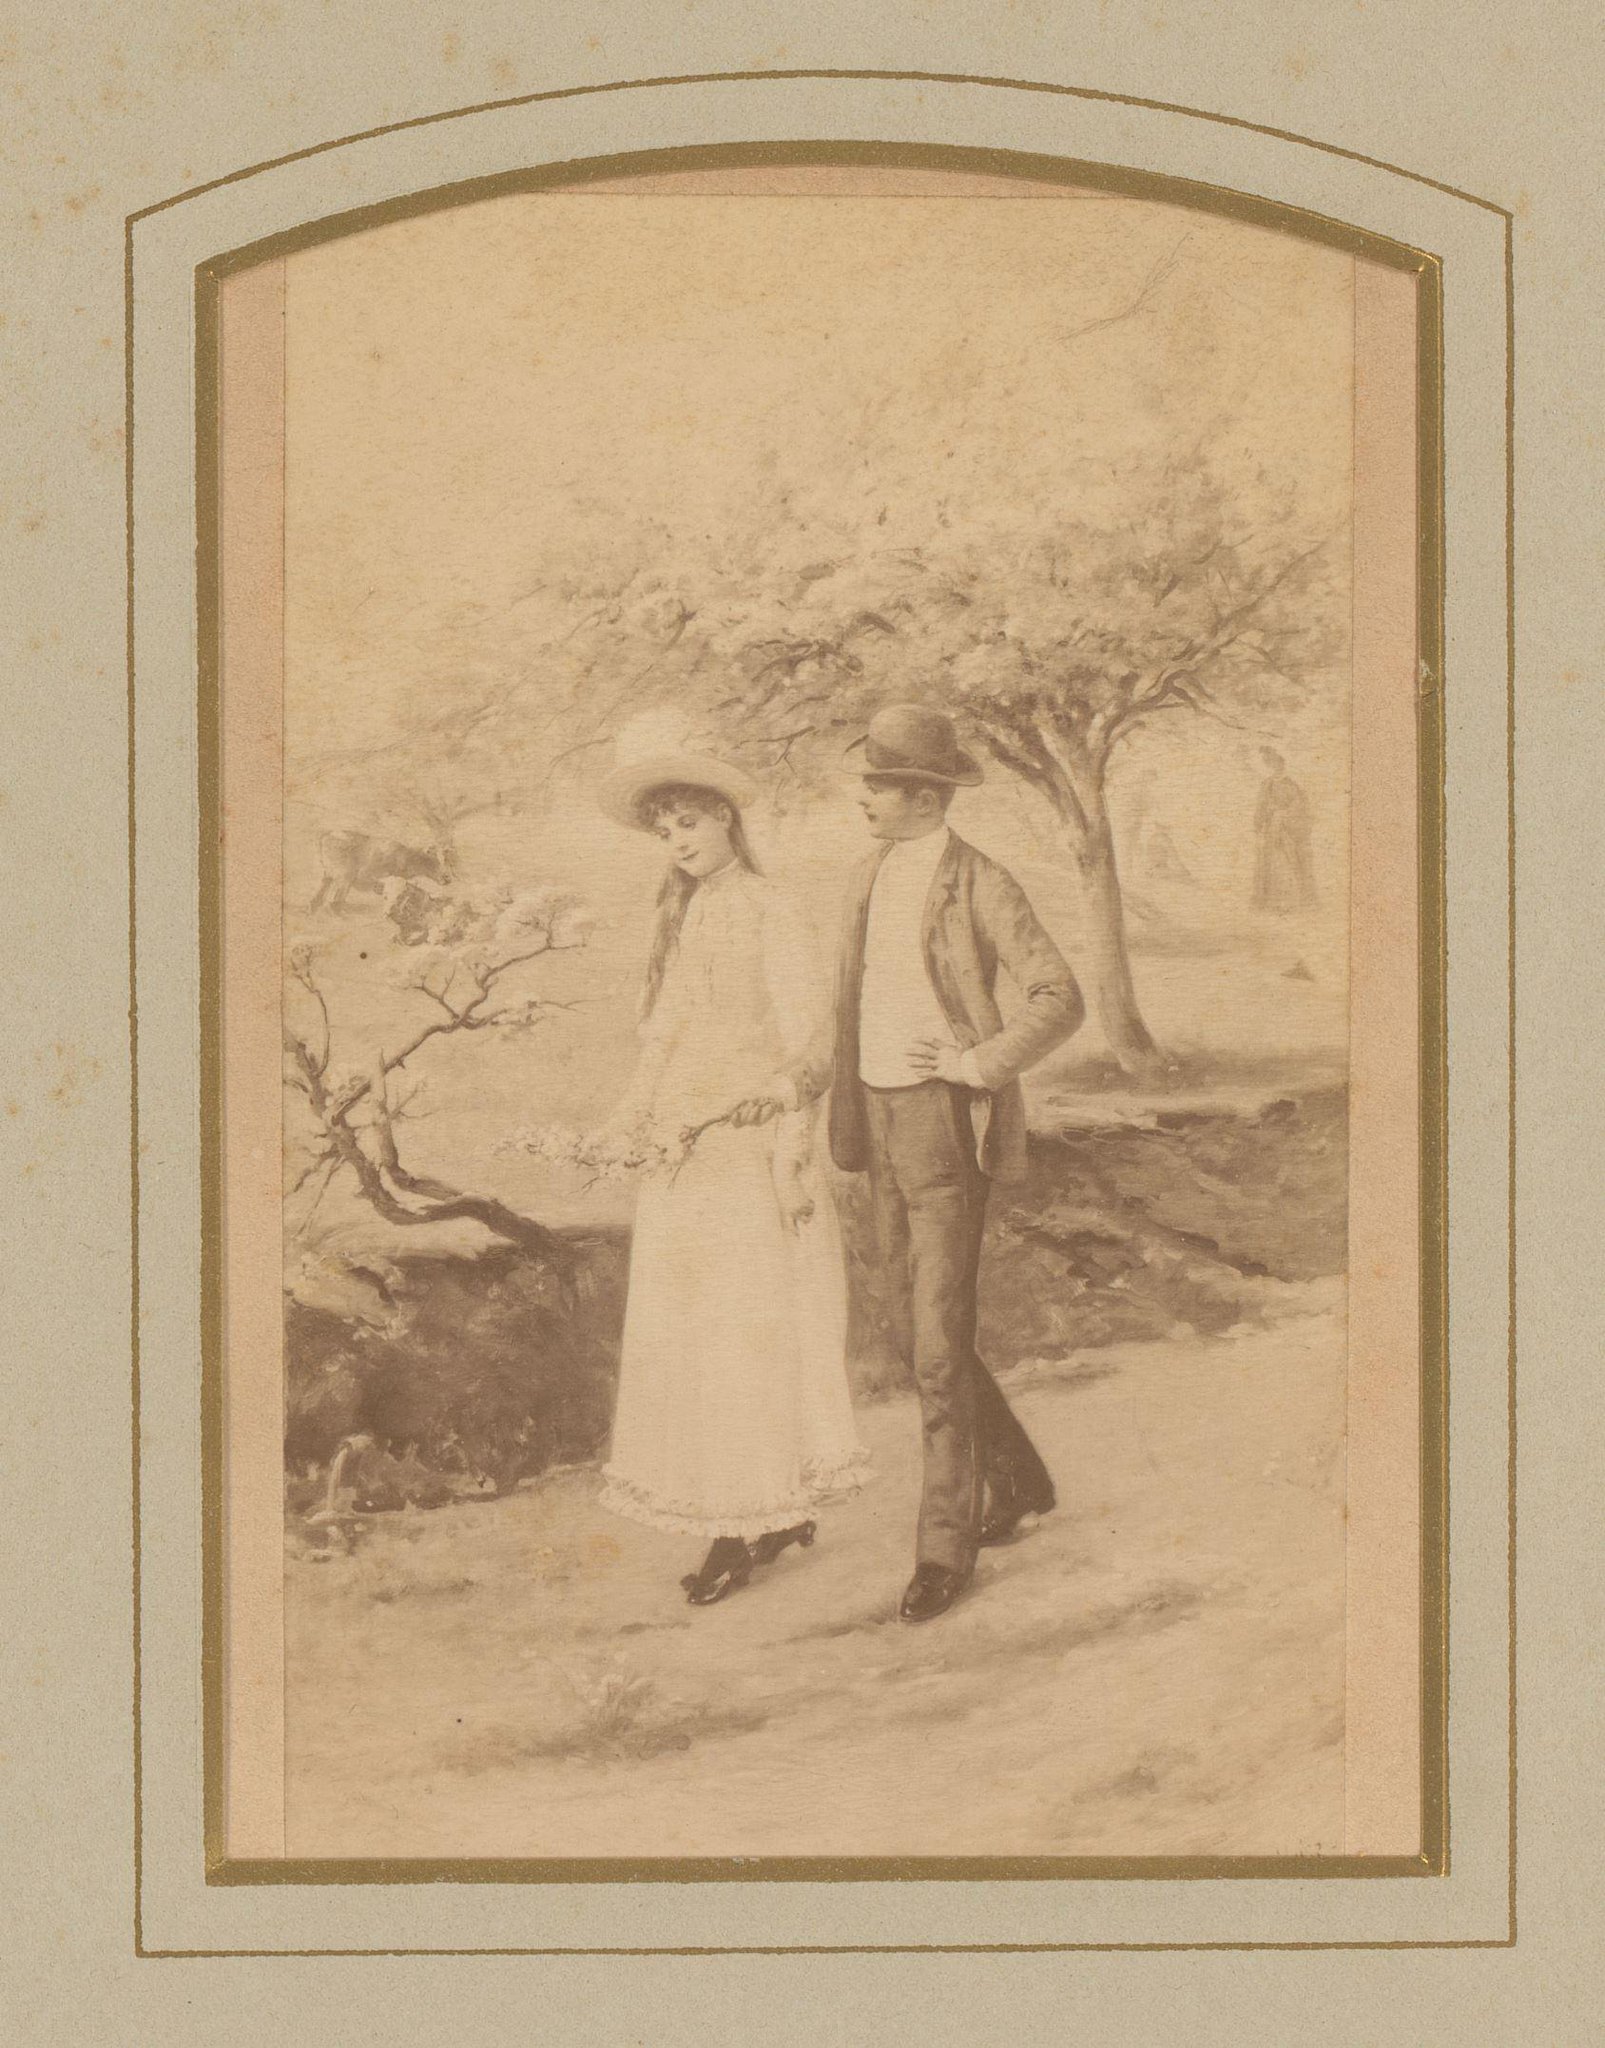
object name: photograph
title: Fotoreproductie van een schilderij van een man en een vrouw tijdens een wandeling door Adolphe Weisz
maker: adolphe weisz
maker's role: painter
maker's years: 1838-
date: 1870-1900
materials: cardboard, photographic support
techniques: albumen print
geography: berlin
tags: adult woman, strolling, adult man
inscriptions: inscription: ‘PHOTOGRAPHISCHE GESELLSCHAFT/ BERLIN’, inscription: ‘2016 - A. Weisz. - I F C/ Vacances de Pâques.’